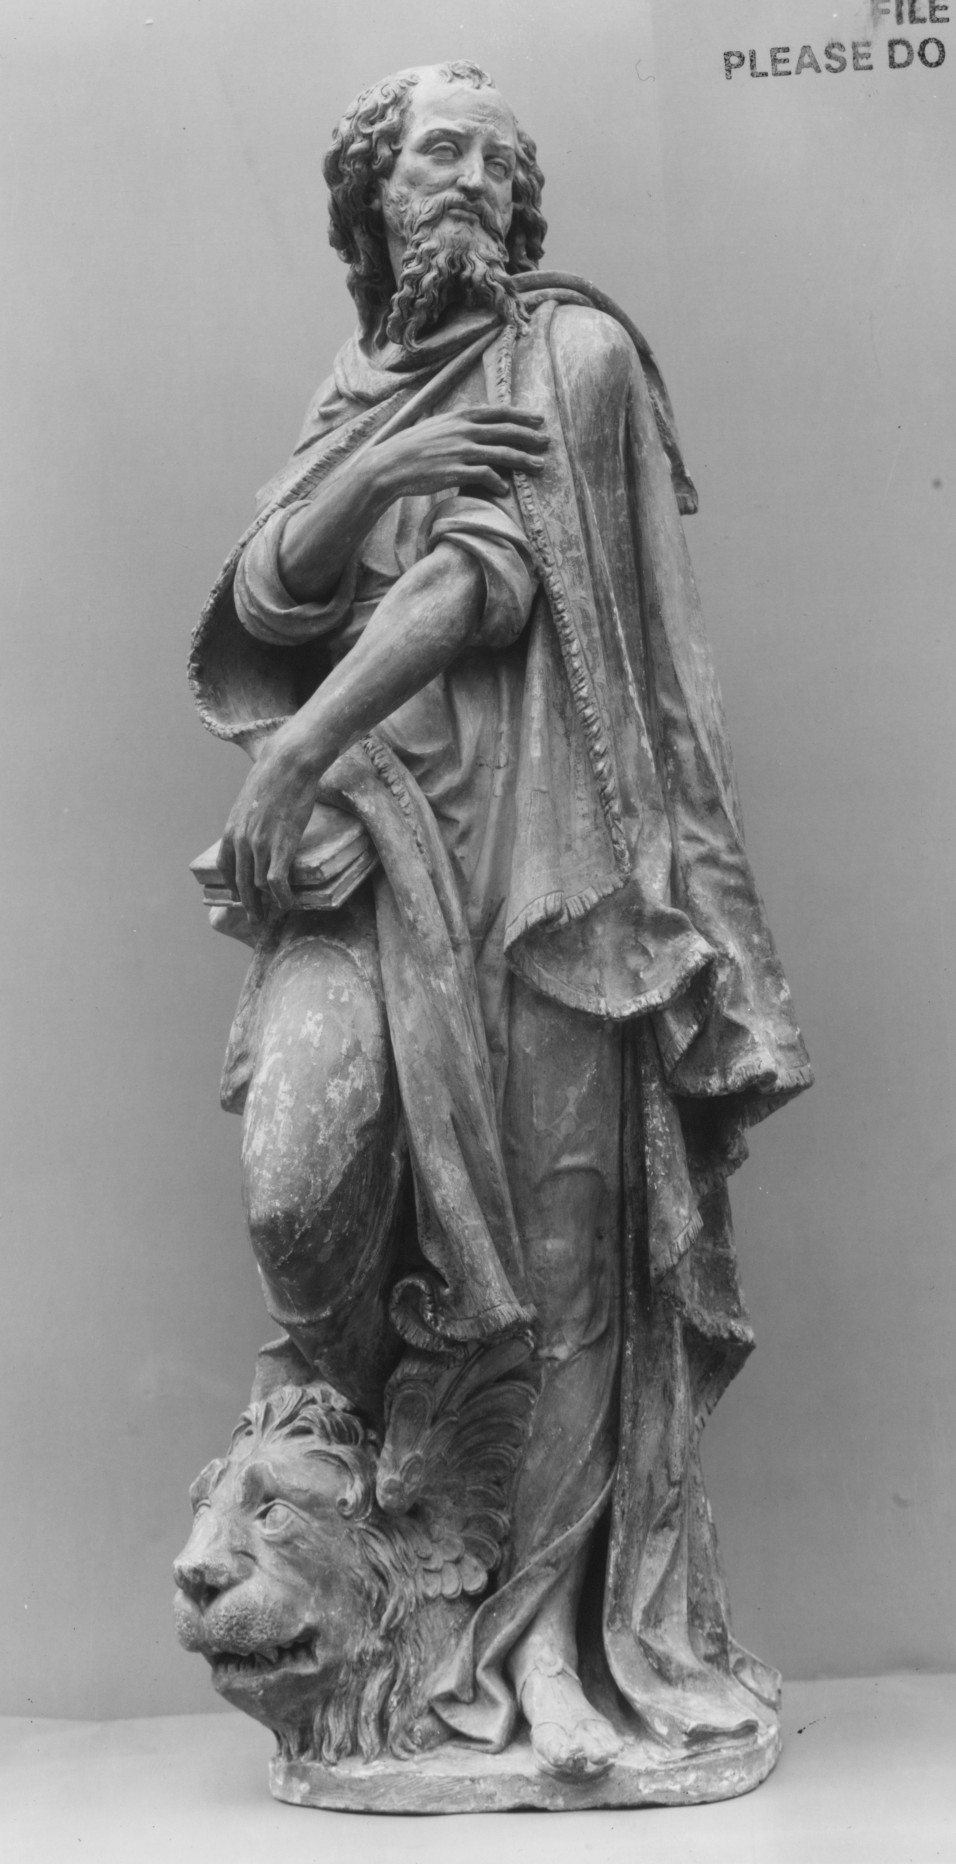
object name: statue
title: Saint Mark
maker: charles hoyau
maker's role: artist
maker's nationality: french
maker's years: 1544-1644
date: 1630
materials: paint, terracotta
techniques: gilding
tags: lions,saint mark